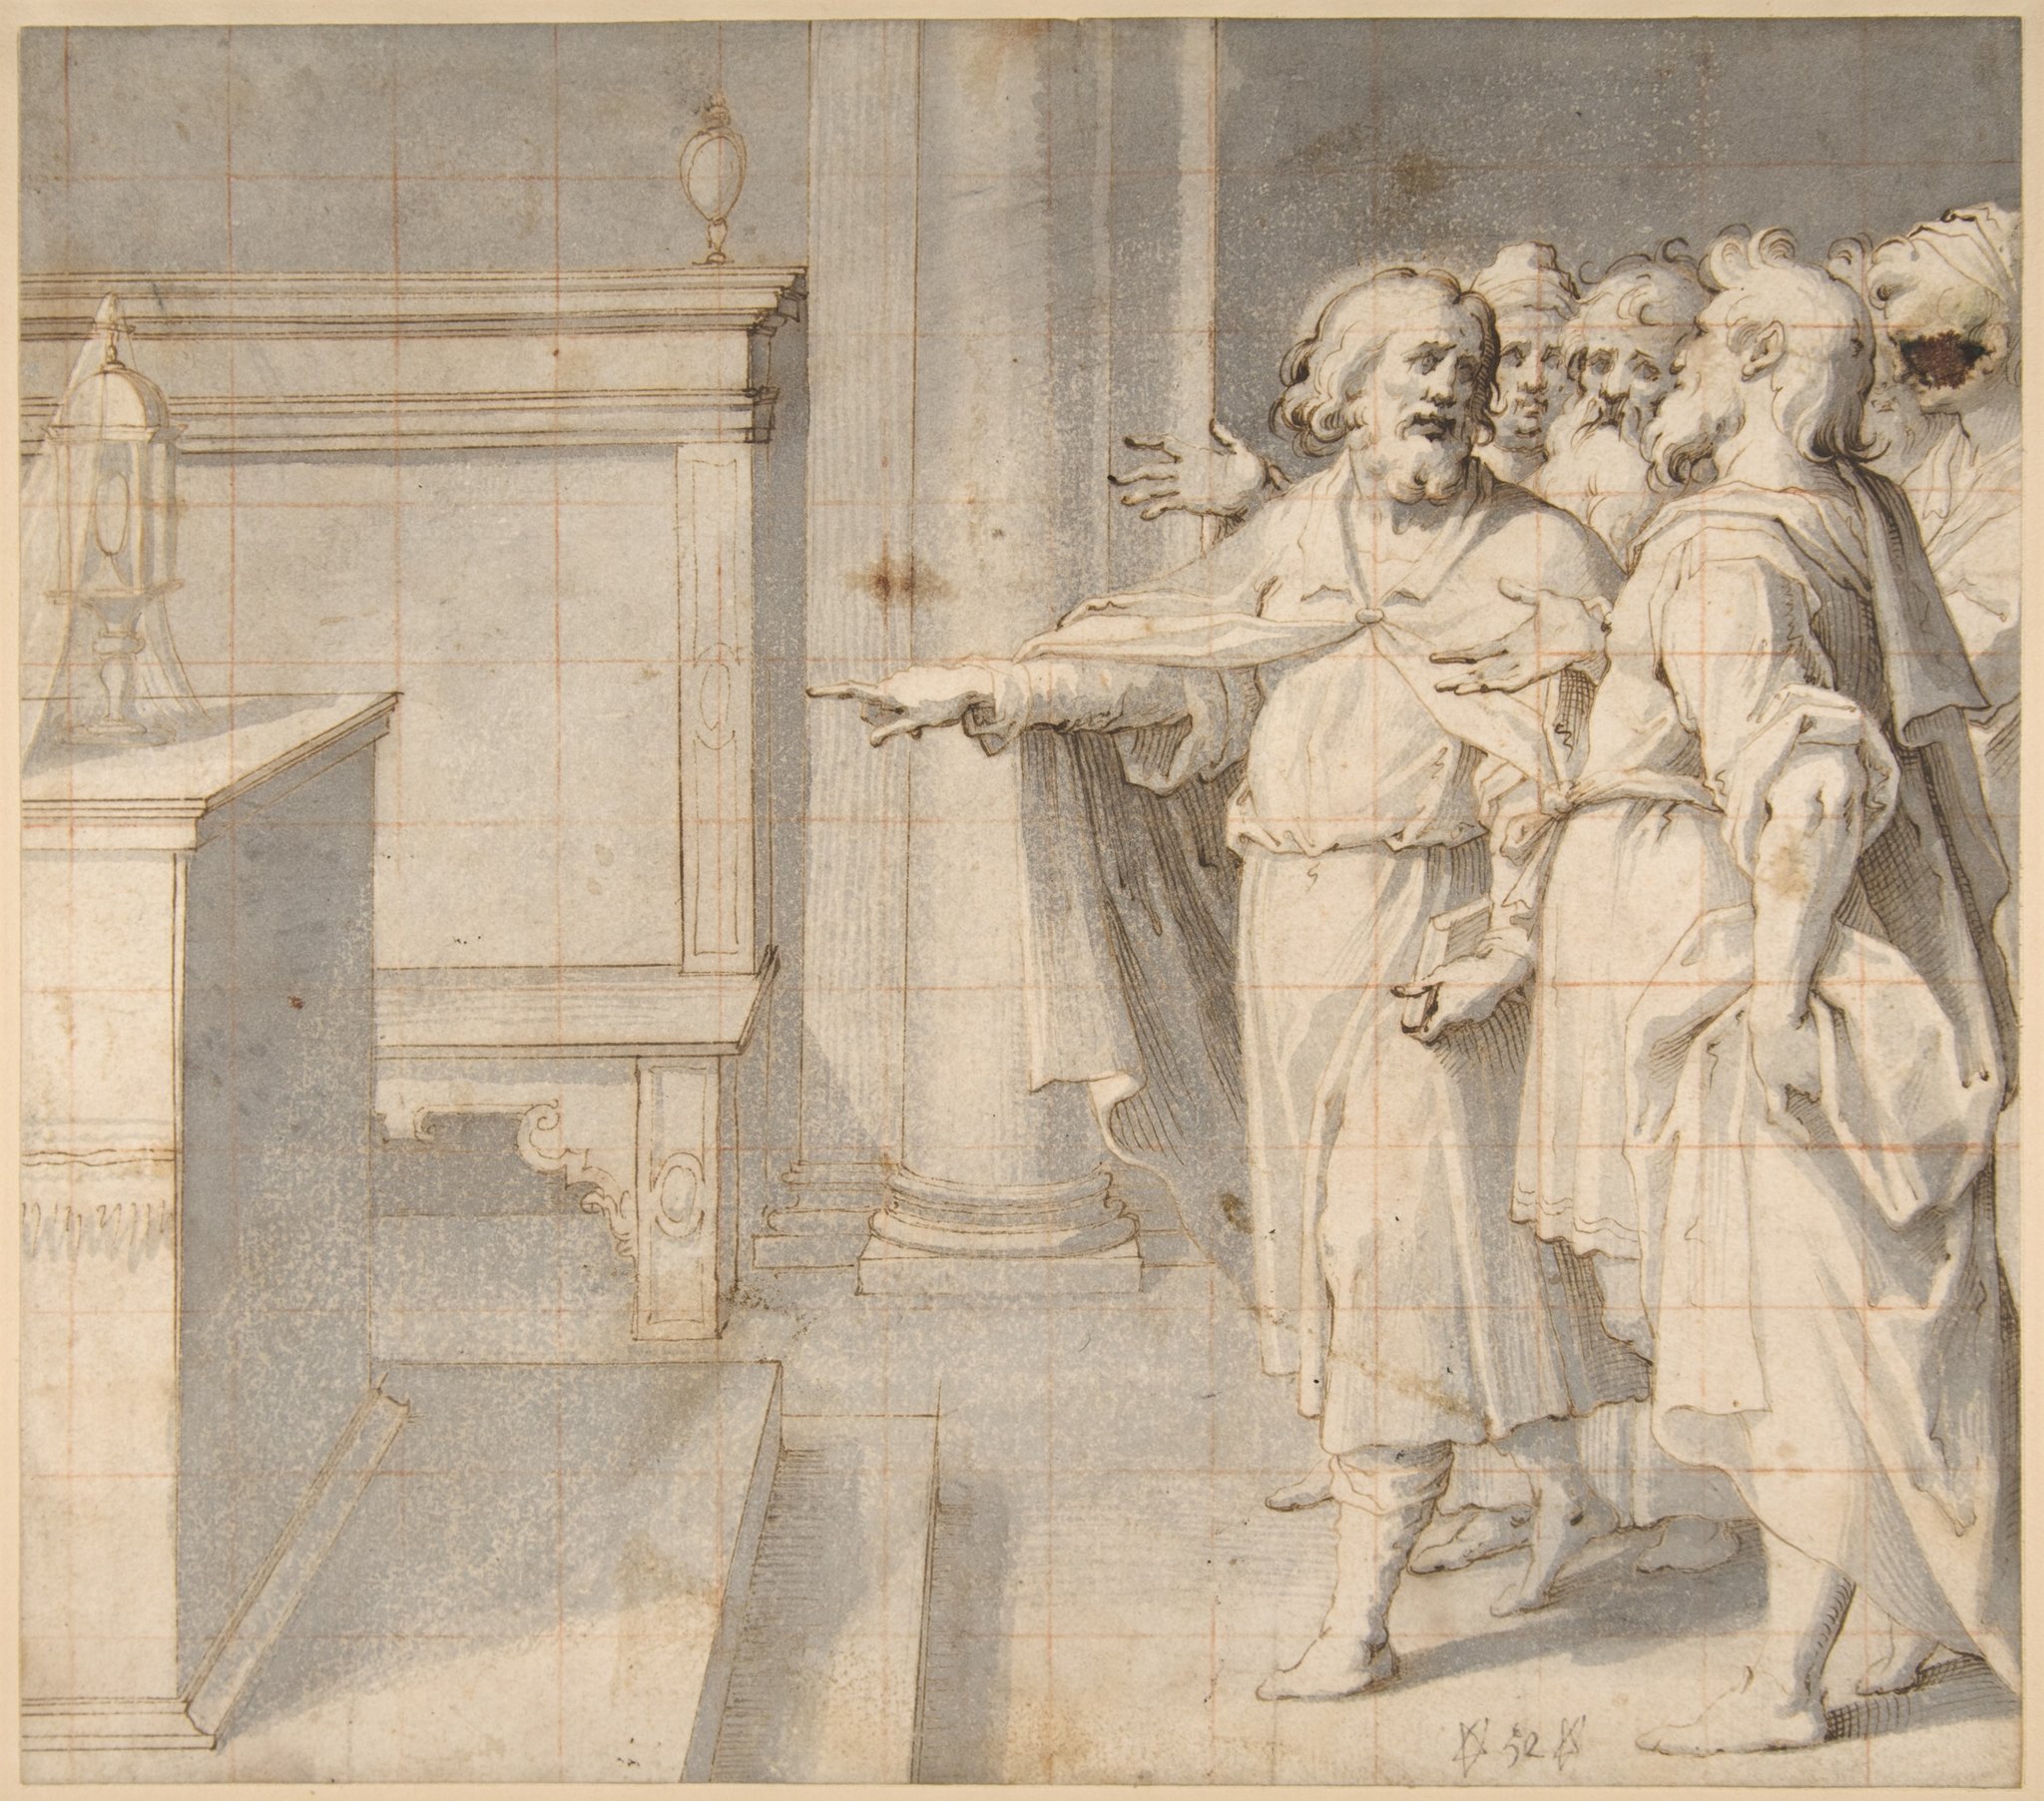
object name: drawing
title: A Male Saint Followed by a Group of Men, Pointing to a Monstrance on an Altar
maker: giovanni battista trotti ("il malosso")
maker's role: artist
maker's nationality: italian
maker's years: 1556-1619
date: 1555-1619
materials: chalk, ink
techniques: brush, pen, drawing, wash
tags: altars,men,saints